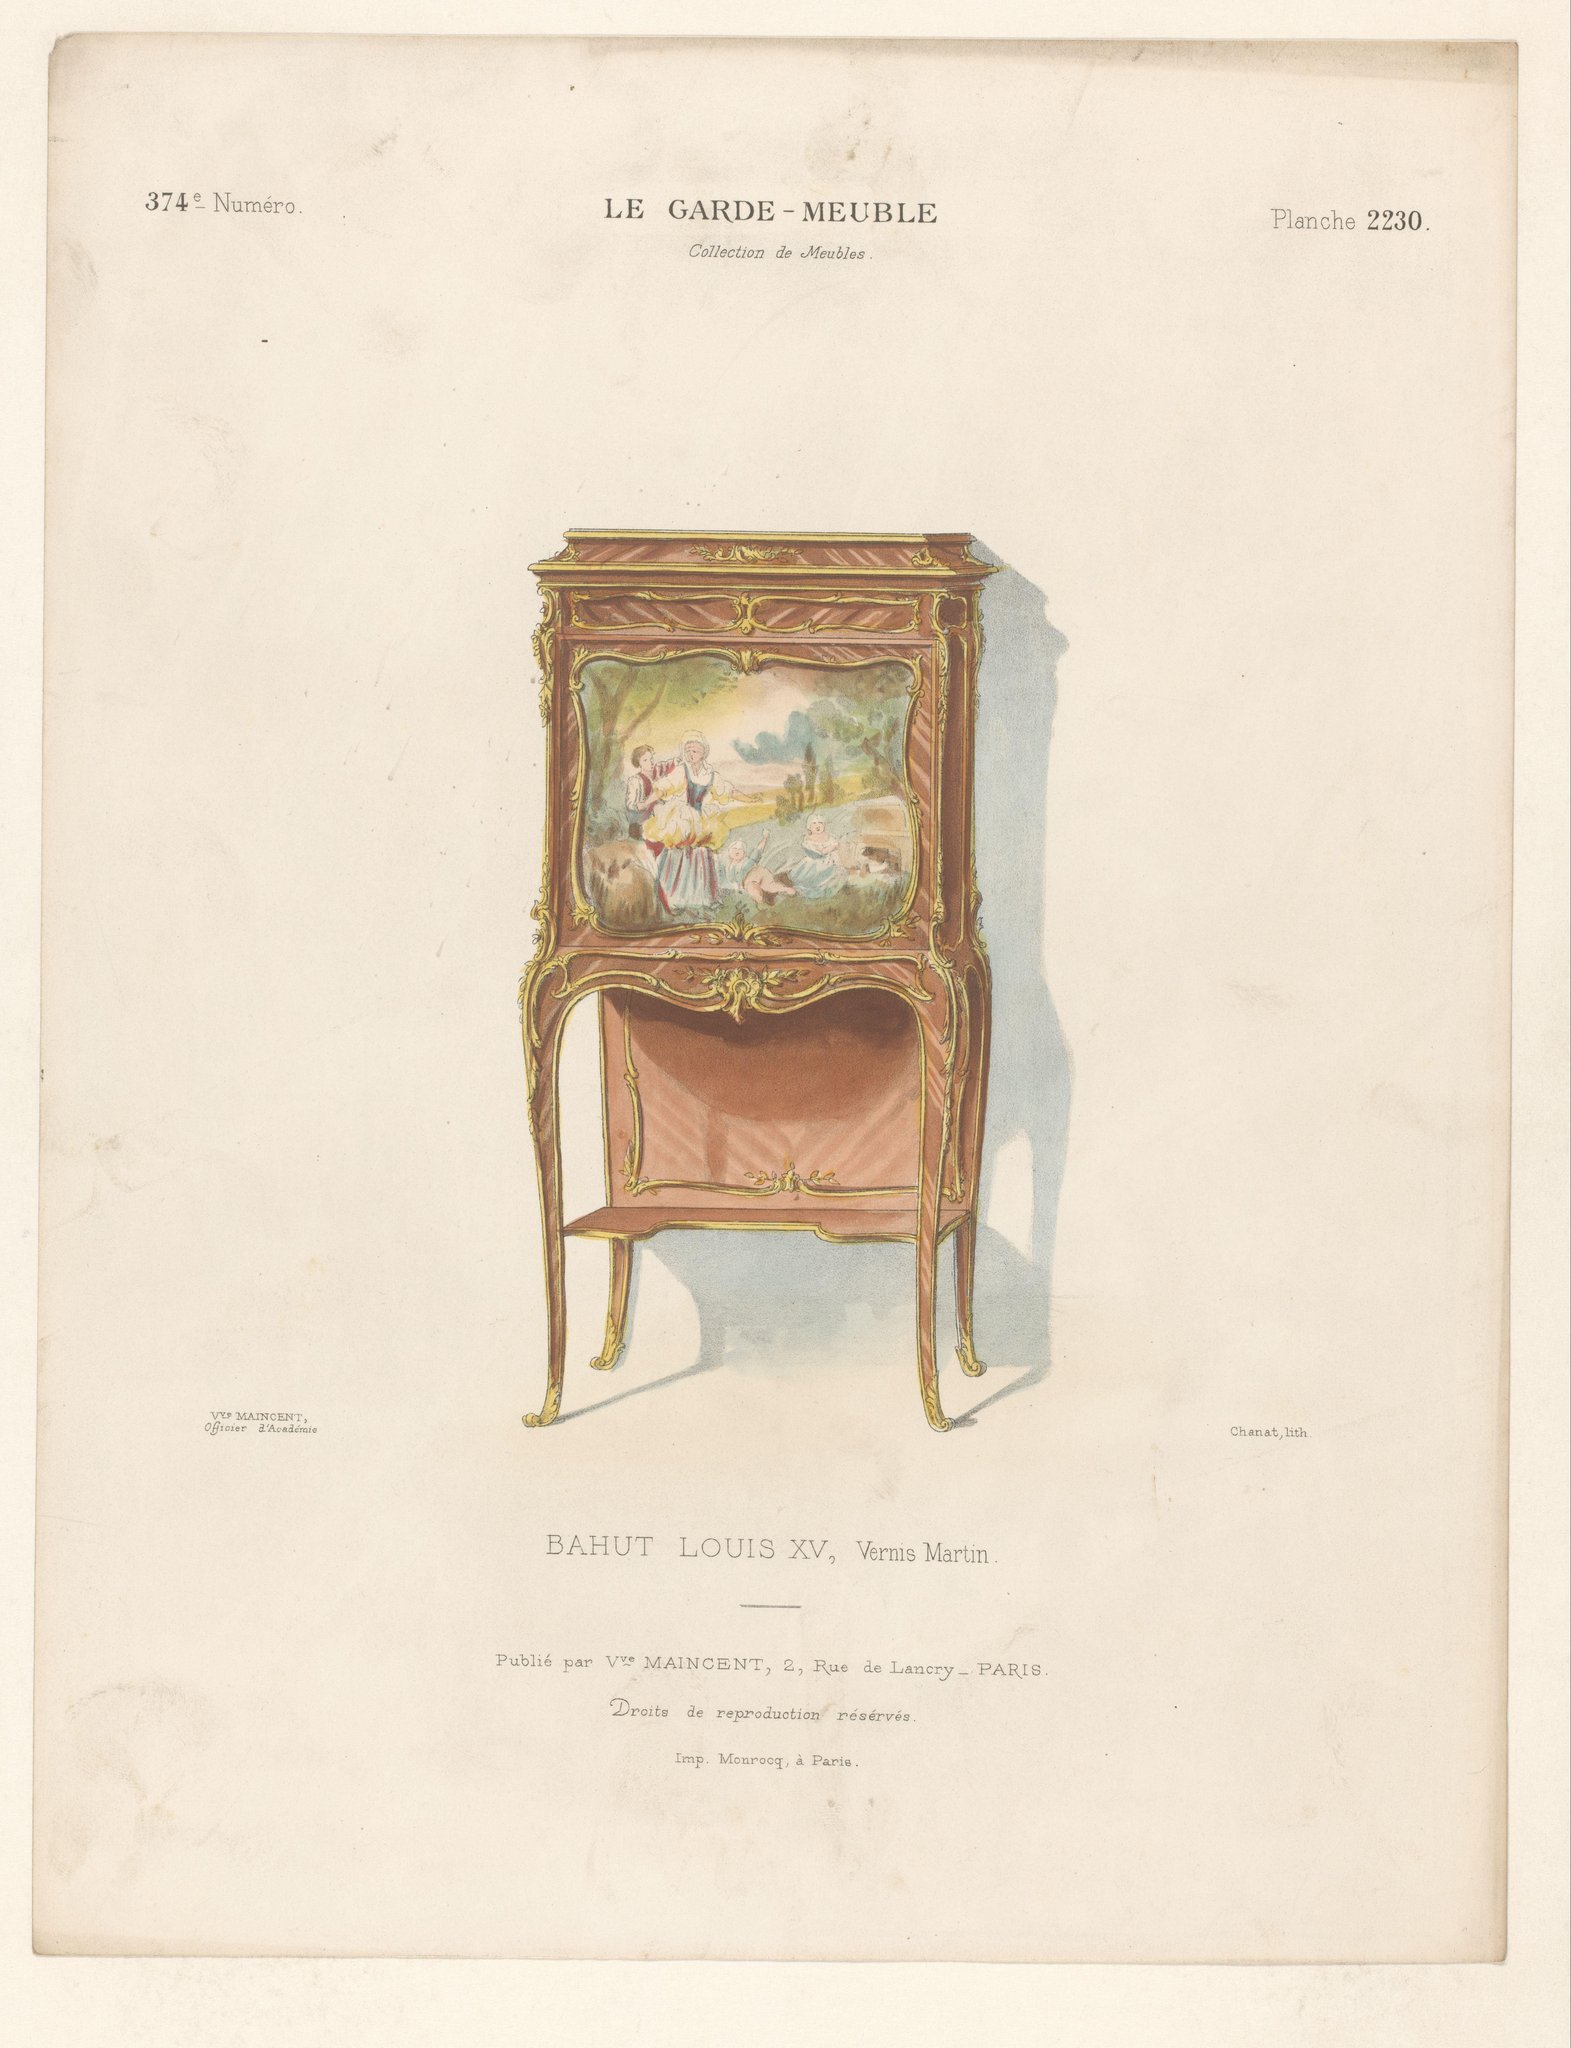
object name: print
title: Le garde-meuble / Collection de Meubles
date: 1895-1935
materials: paper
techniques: hand coloring, lithograph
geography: paris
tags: furniture for storage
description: Ieder Livraison in de serie Le Garde-Meuble bevat negen platen: drie 'sièges' (zitmeubels), drie 'meubles' (diverse meubels zoals tafels en kasten) en drie 'tentures' (gordijnen en draperieën).